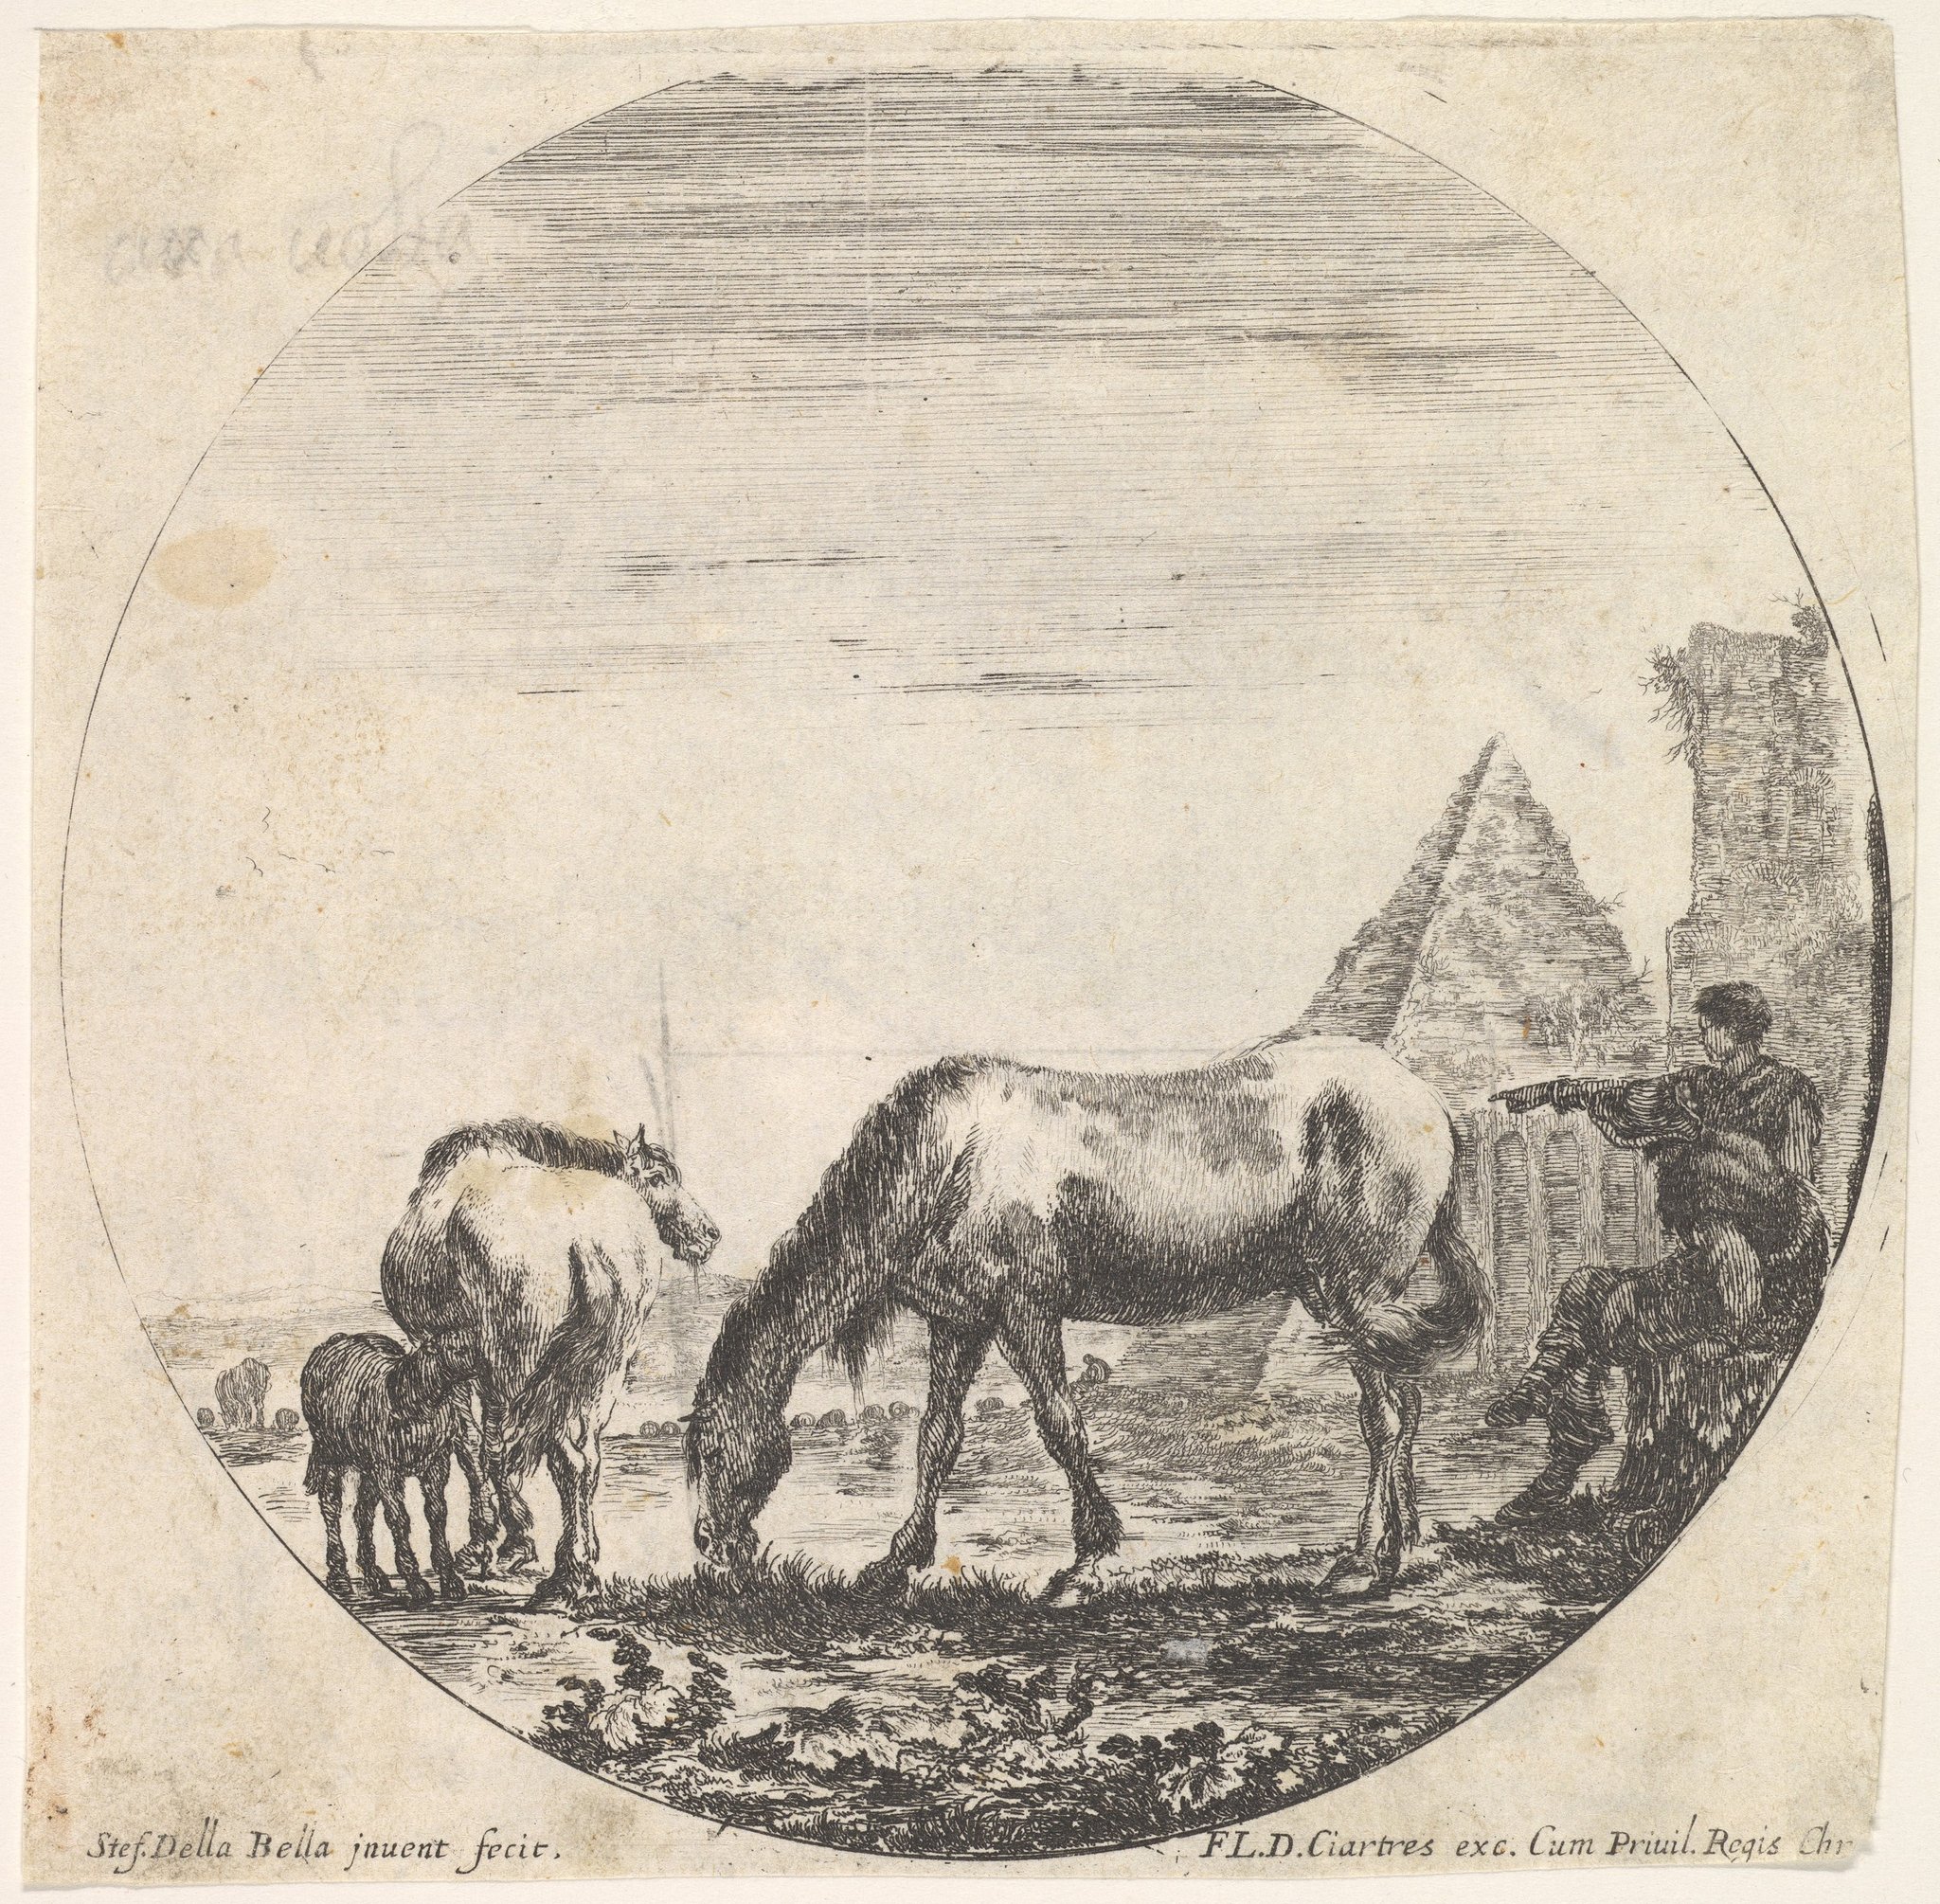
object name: print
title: Plate 11: the pyramid of Caius Cestius, a horse grazing, a foal suckling a mare, a seated shepherd and another standing, from "Roman landscapes and ruins" (Paysages et ruines de Rome)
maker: stefano della bella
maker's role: artist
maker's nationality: italian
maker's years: 1610-1664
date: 1643-1648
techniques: etching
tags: pyramids,horses,landscapes,shepherds